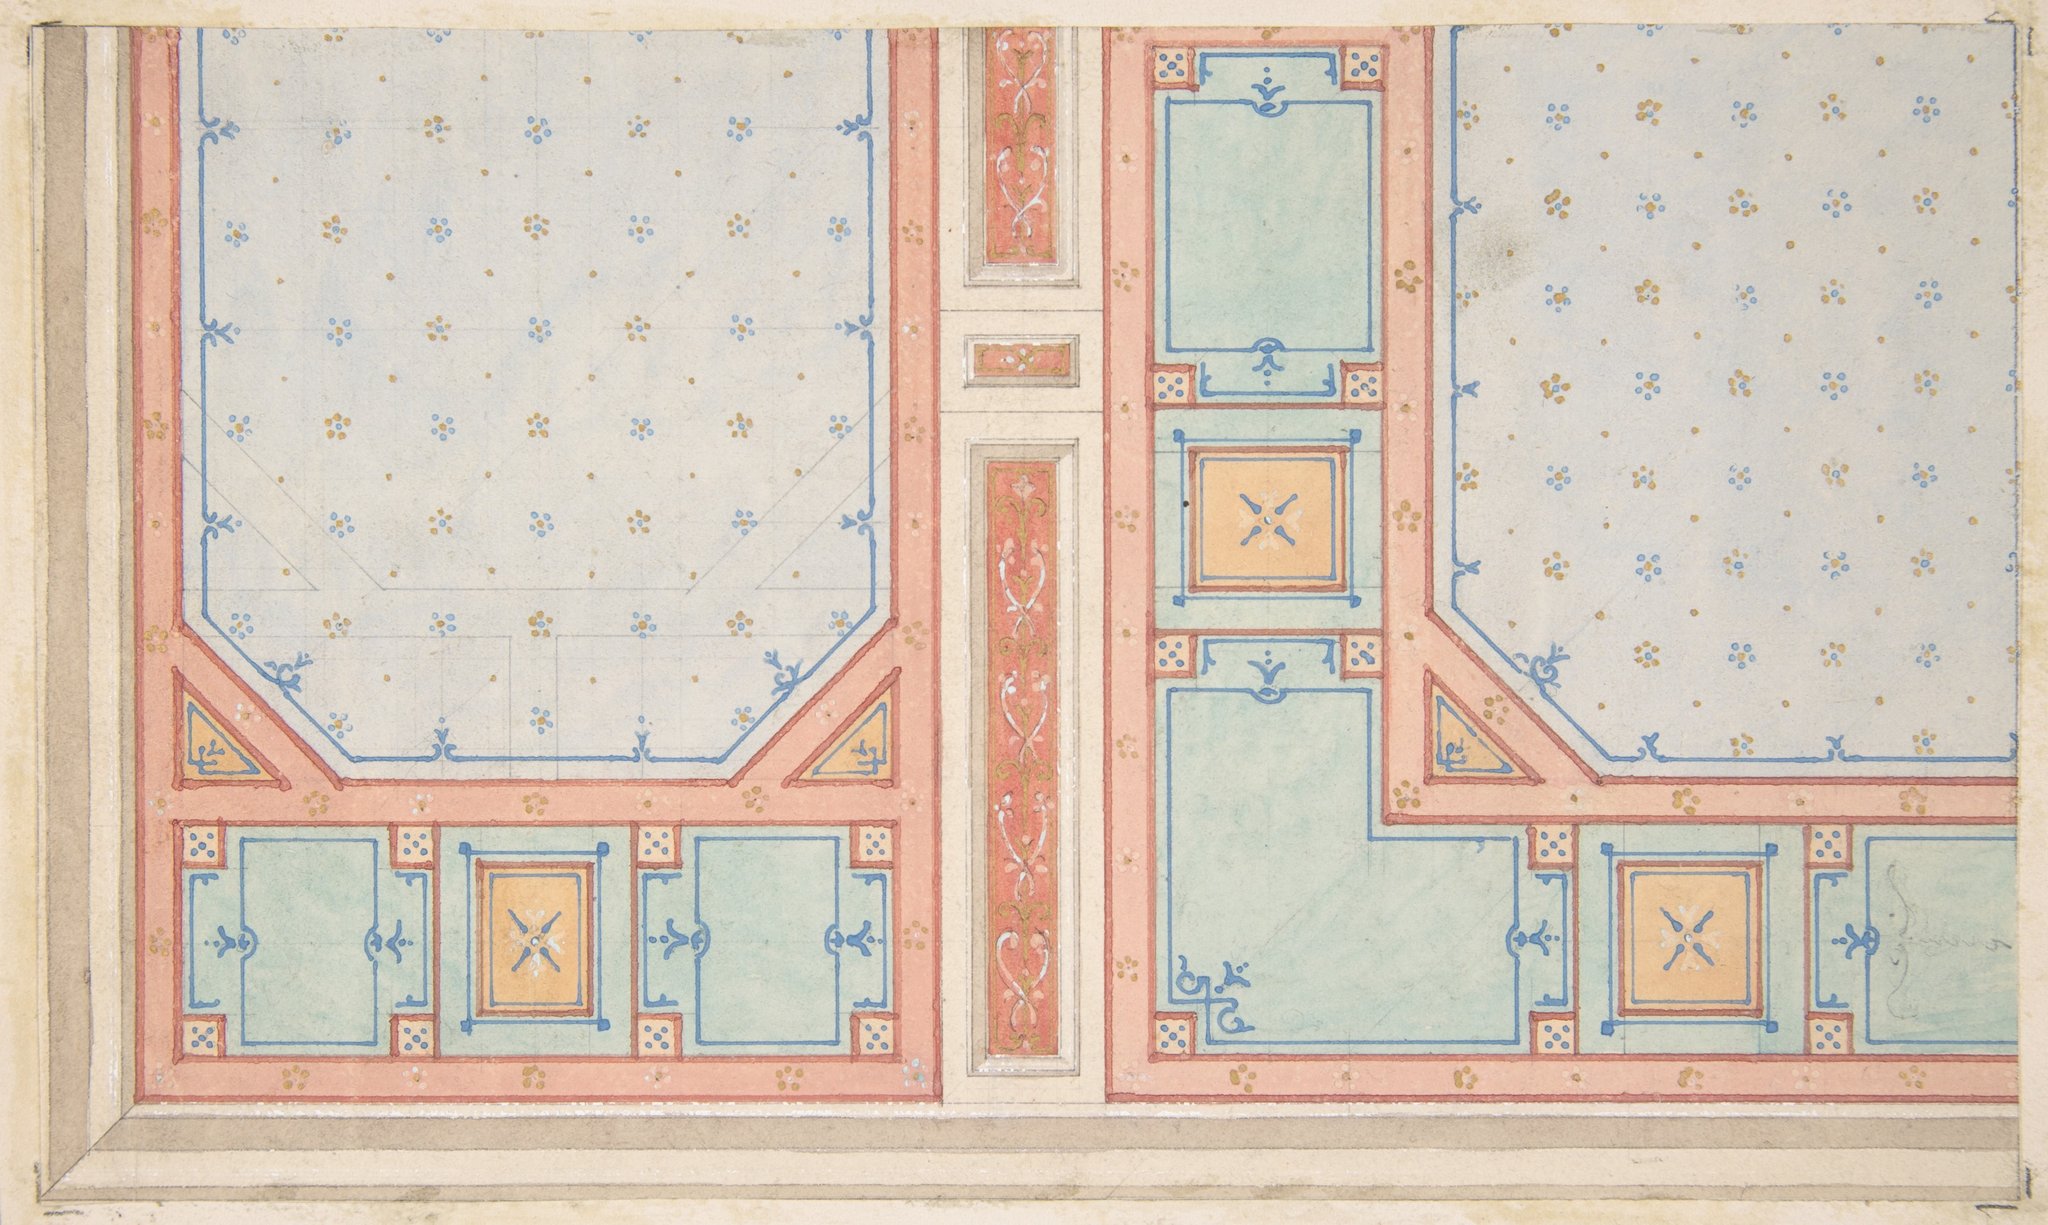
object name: drawing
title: Design for a ceiling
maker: jules-edmond-charles lachaise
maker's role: artist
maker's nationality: french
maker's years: 1897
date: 1851-1900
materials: gilt, gouache, graphite, watercolor